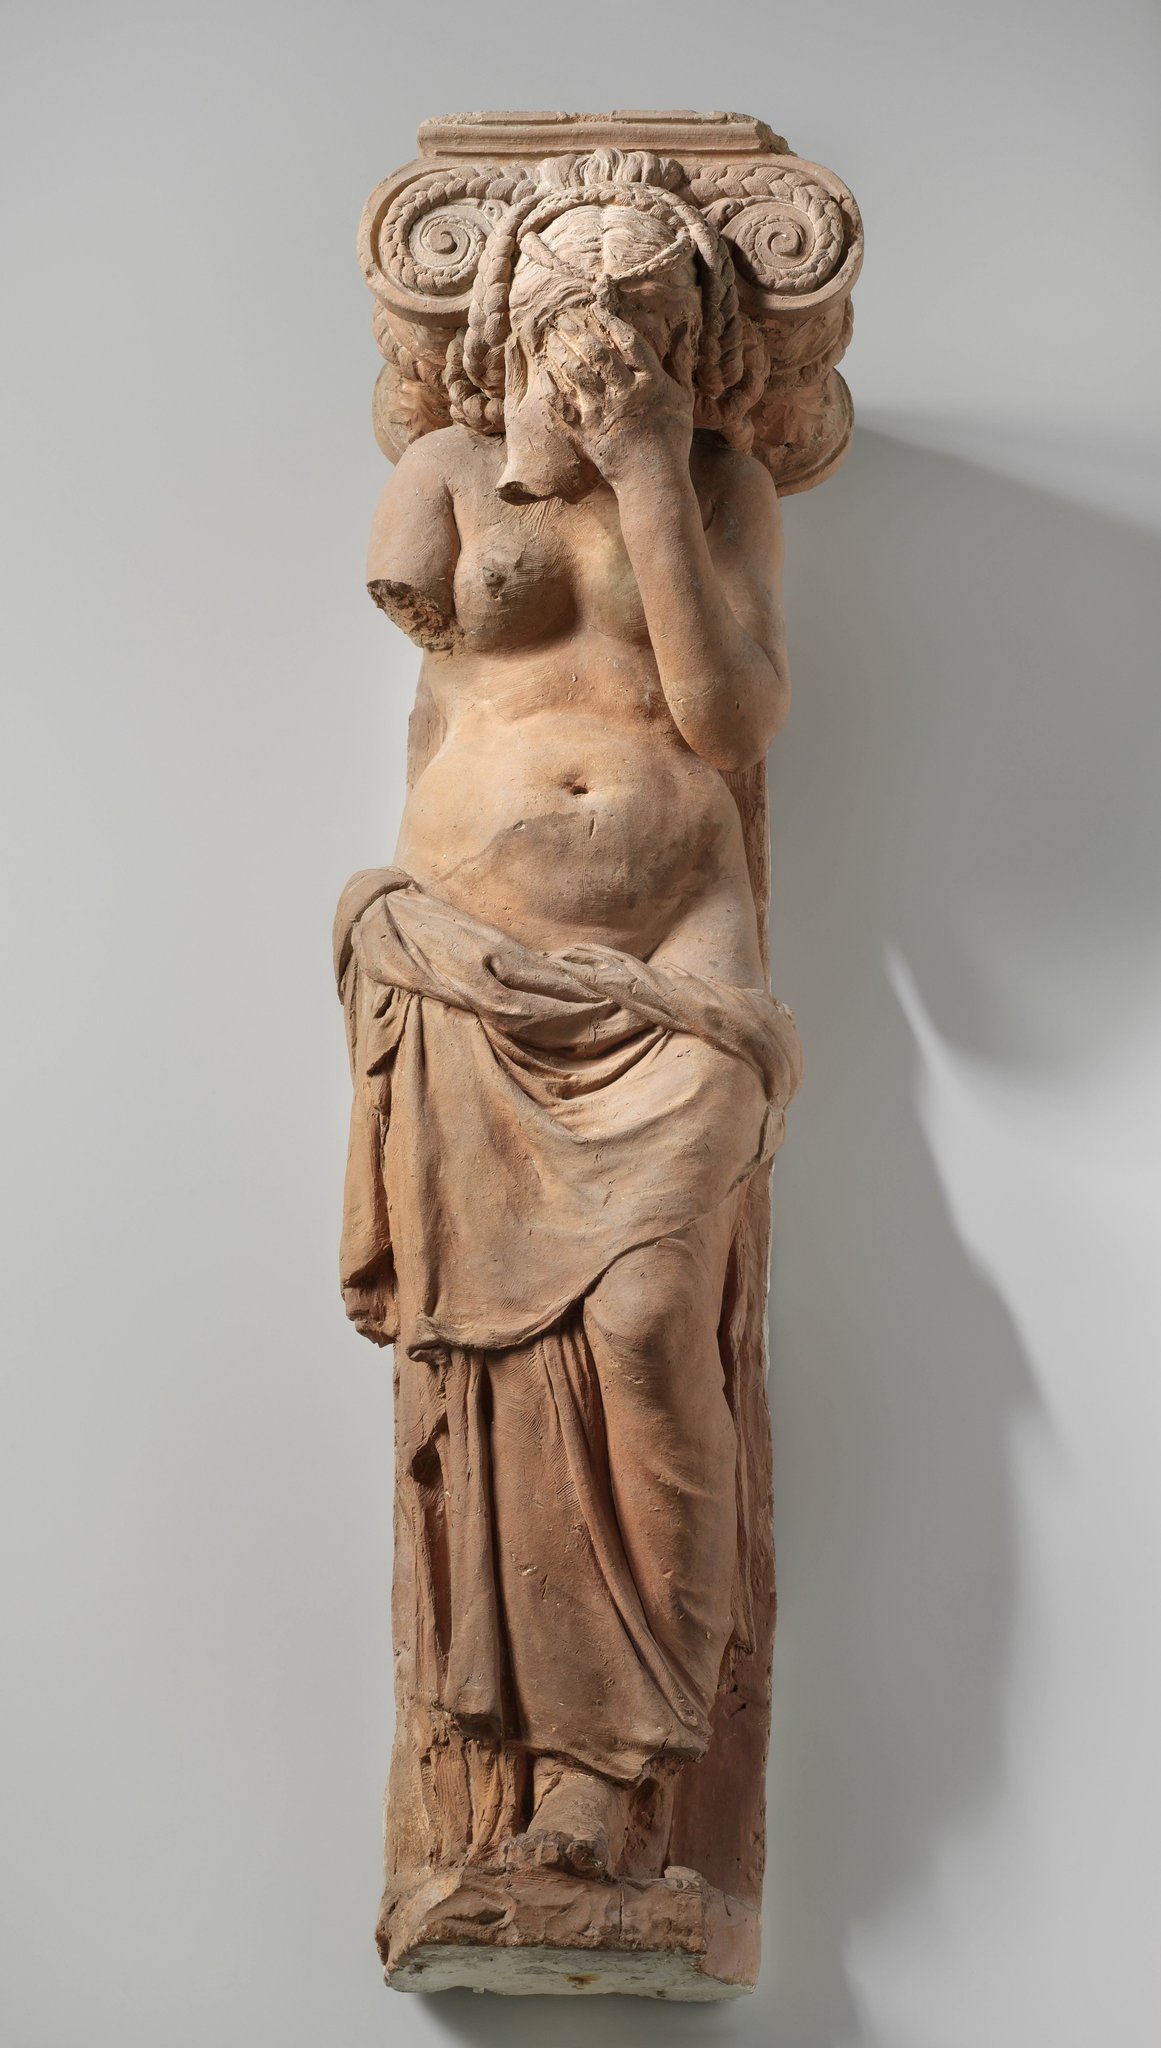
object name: model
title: Penitence, Model for a Caryatid in the Vierschaar of the Amsterdam Town Hall (now Royal Palace) at Dam Square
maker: artus quellinus (i)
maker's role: draughtsman, print maker, sculptor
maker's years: 1609-1668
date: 1650-1651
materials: terracotta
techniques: modeling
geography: amsterdam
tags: penitence, repentance; 'penitenza', 'pentimento', 'pentimento de'peccati', 'purgatione de peccati' (ripa), caryatids ~ architecture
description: Between the reliefs in the Vierschaar (Tribunal), or court of justice, in the Amsterdam Town Hall, Quellinus placed four female caryatids – weight-bearing sculpted figures – personifying Remorse (with their hands covering their face) and Penance (with bound hands).